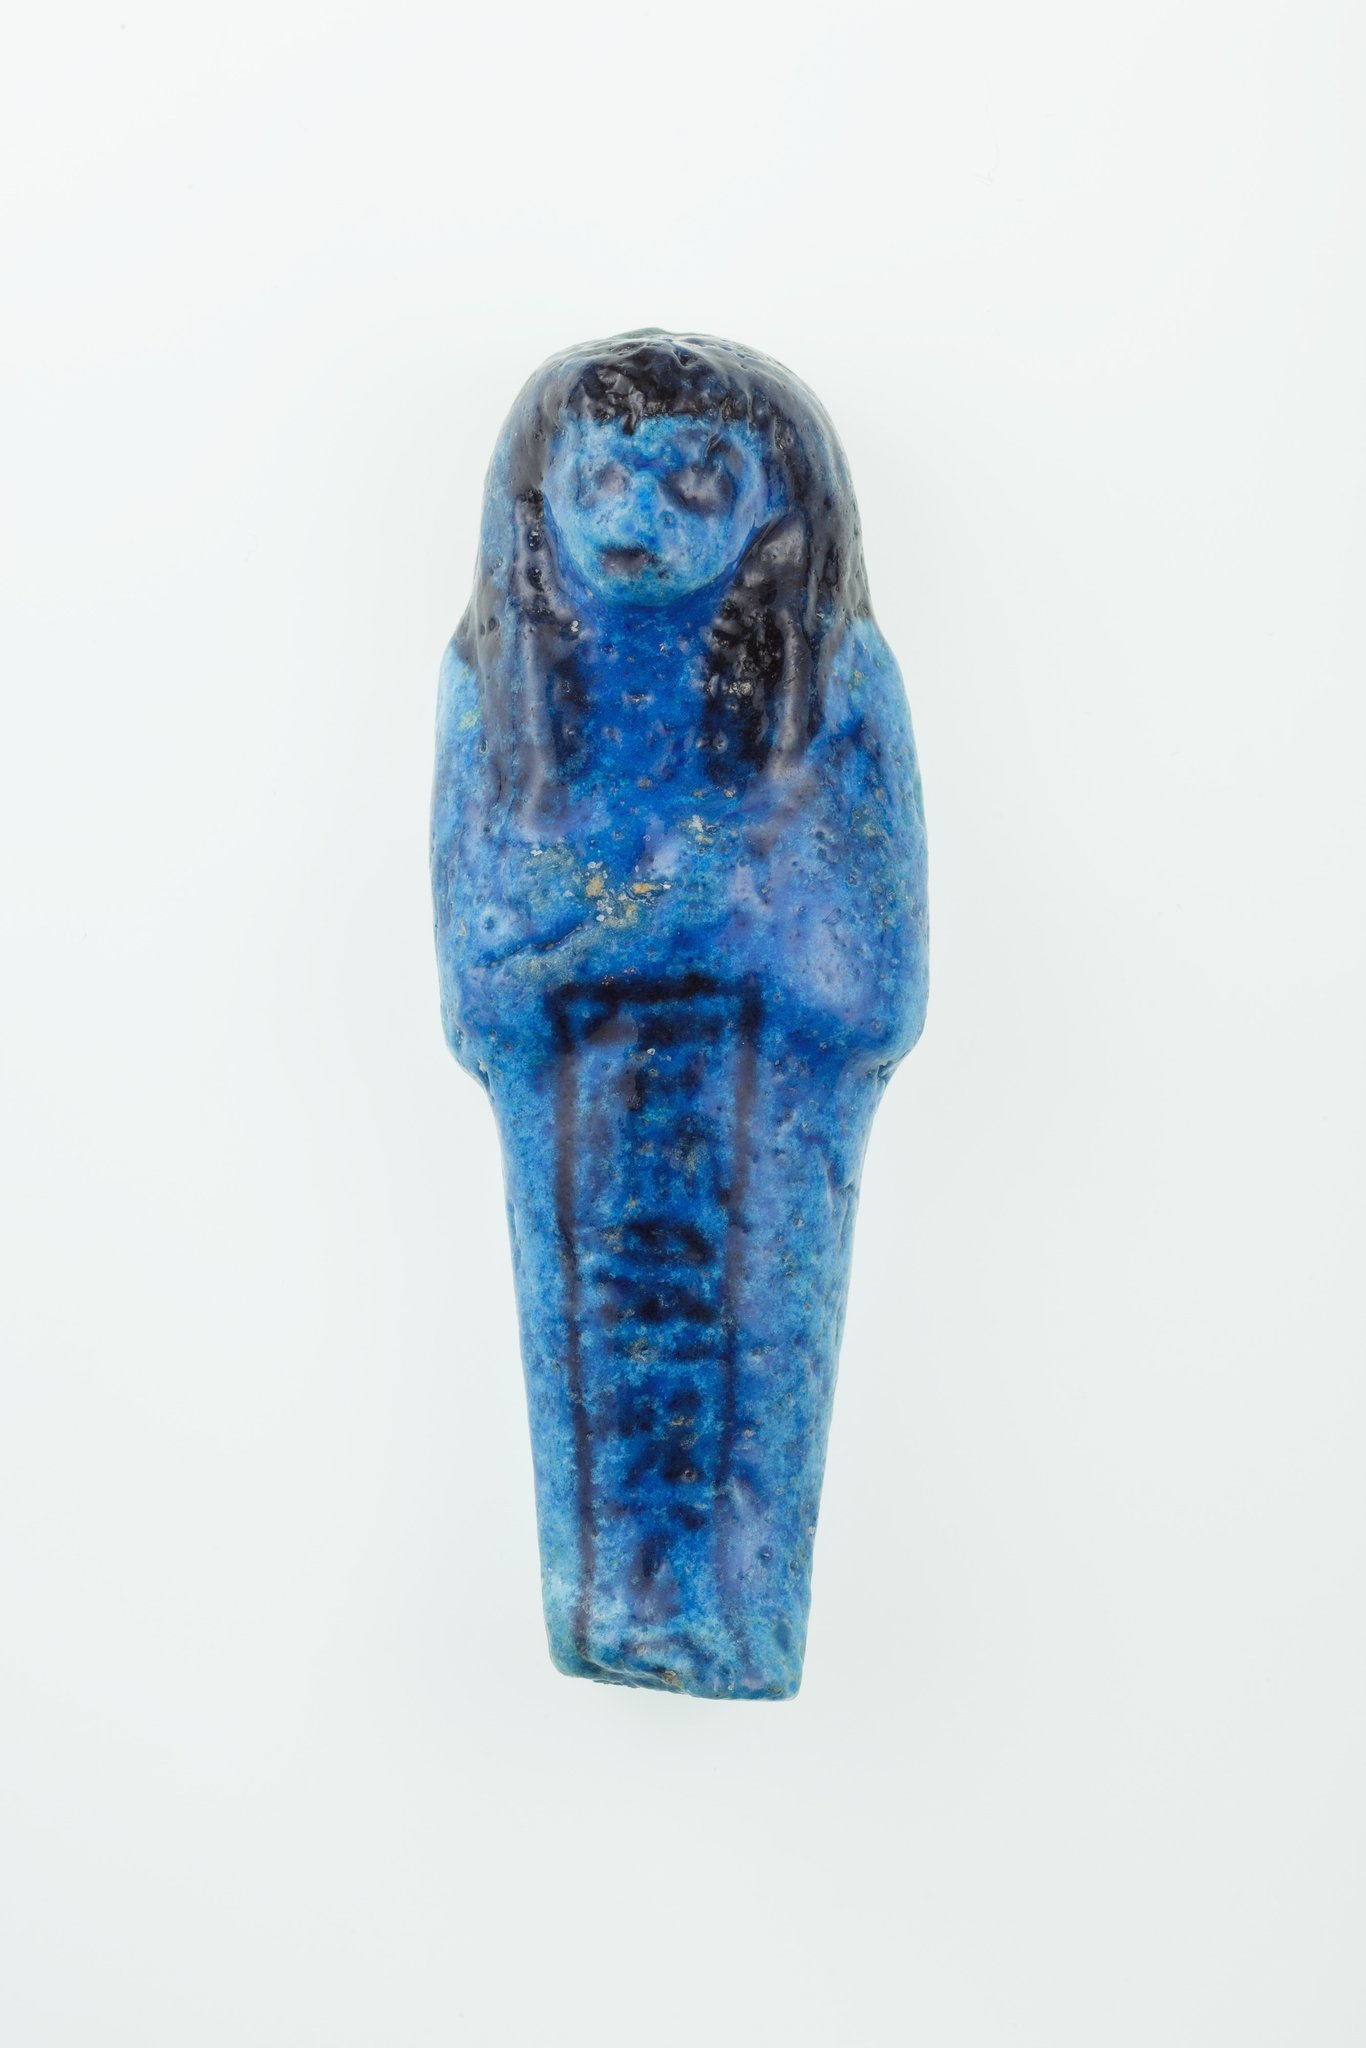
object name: shabti, worker, nauny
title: Worker Shabti of Nauny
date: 1050 BCE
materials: faience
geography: egypt